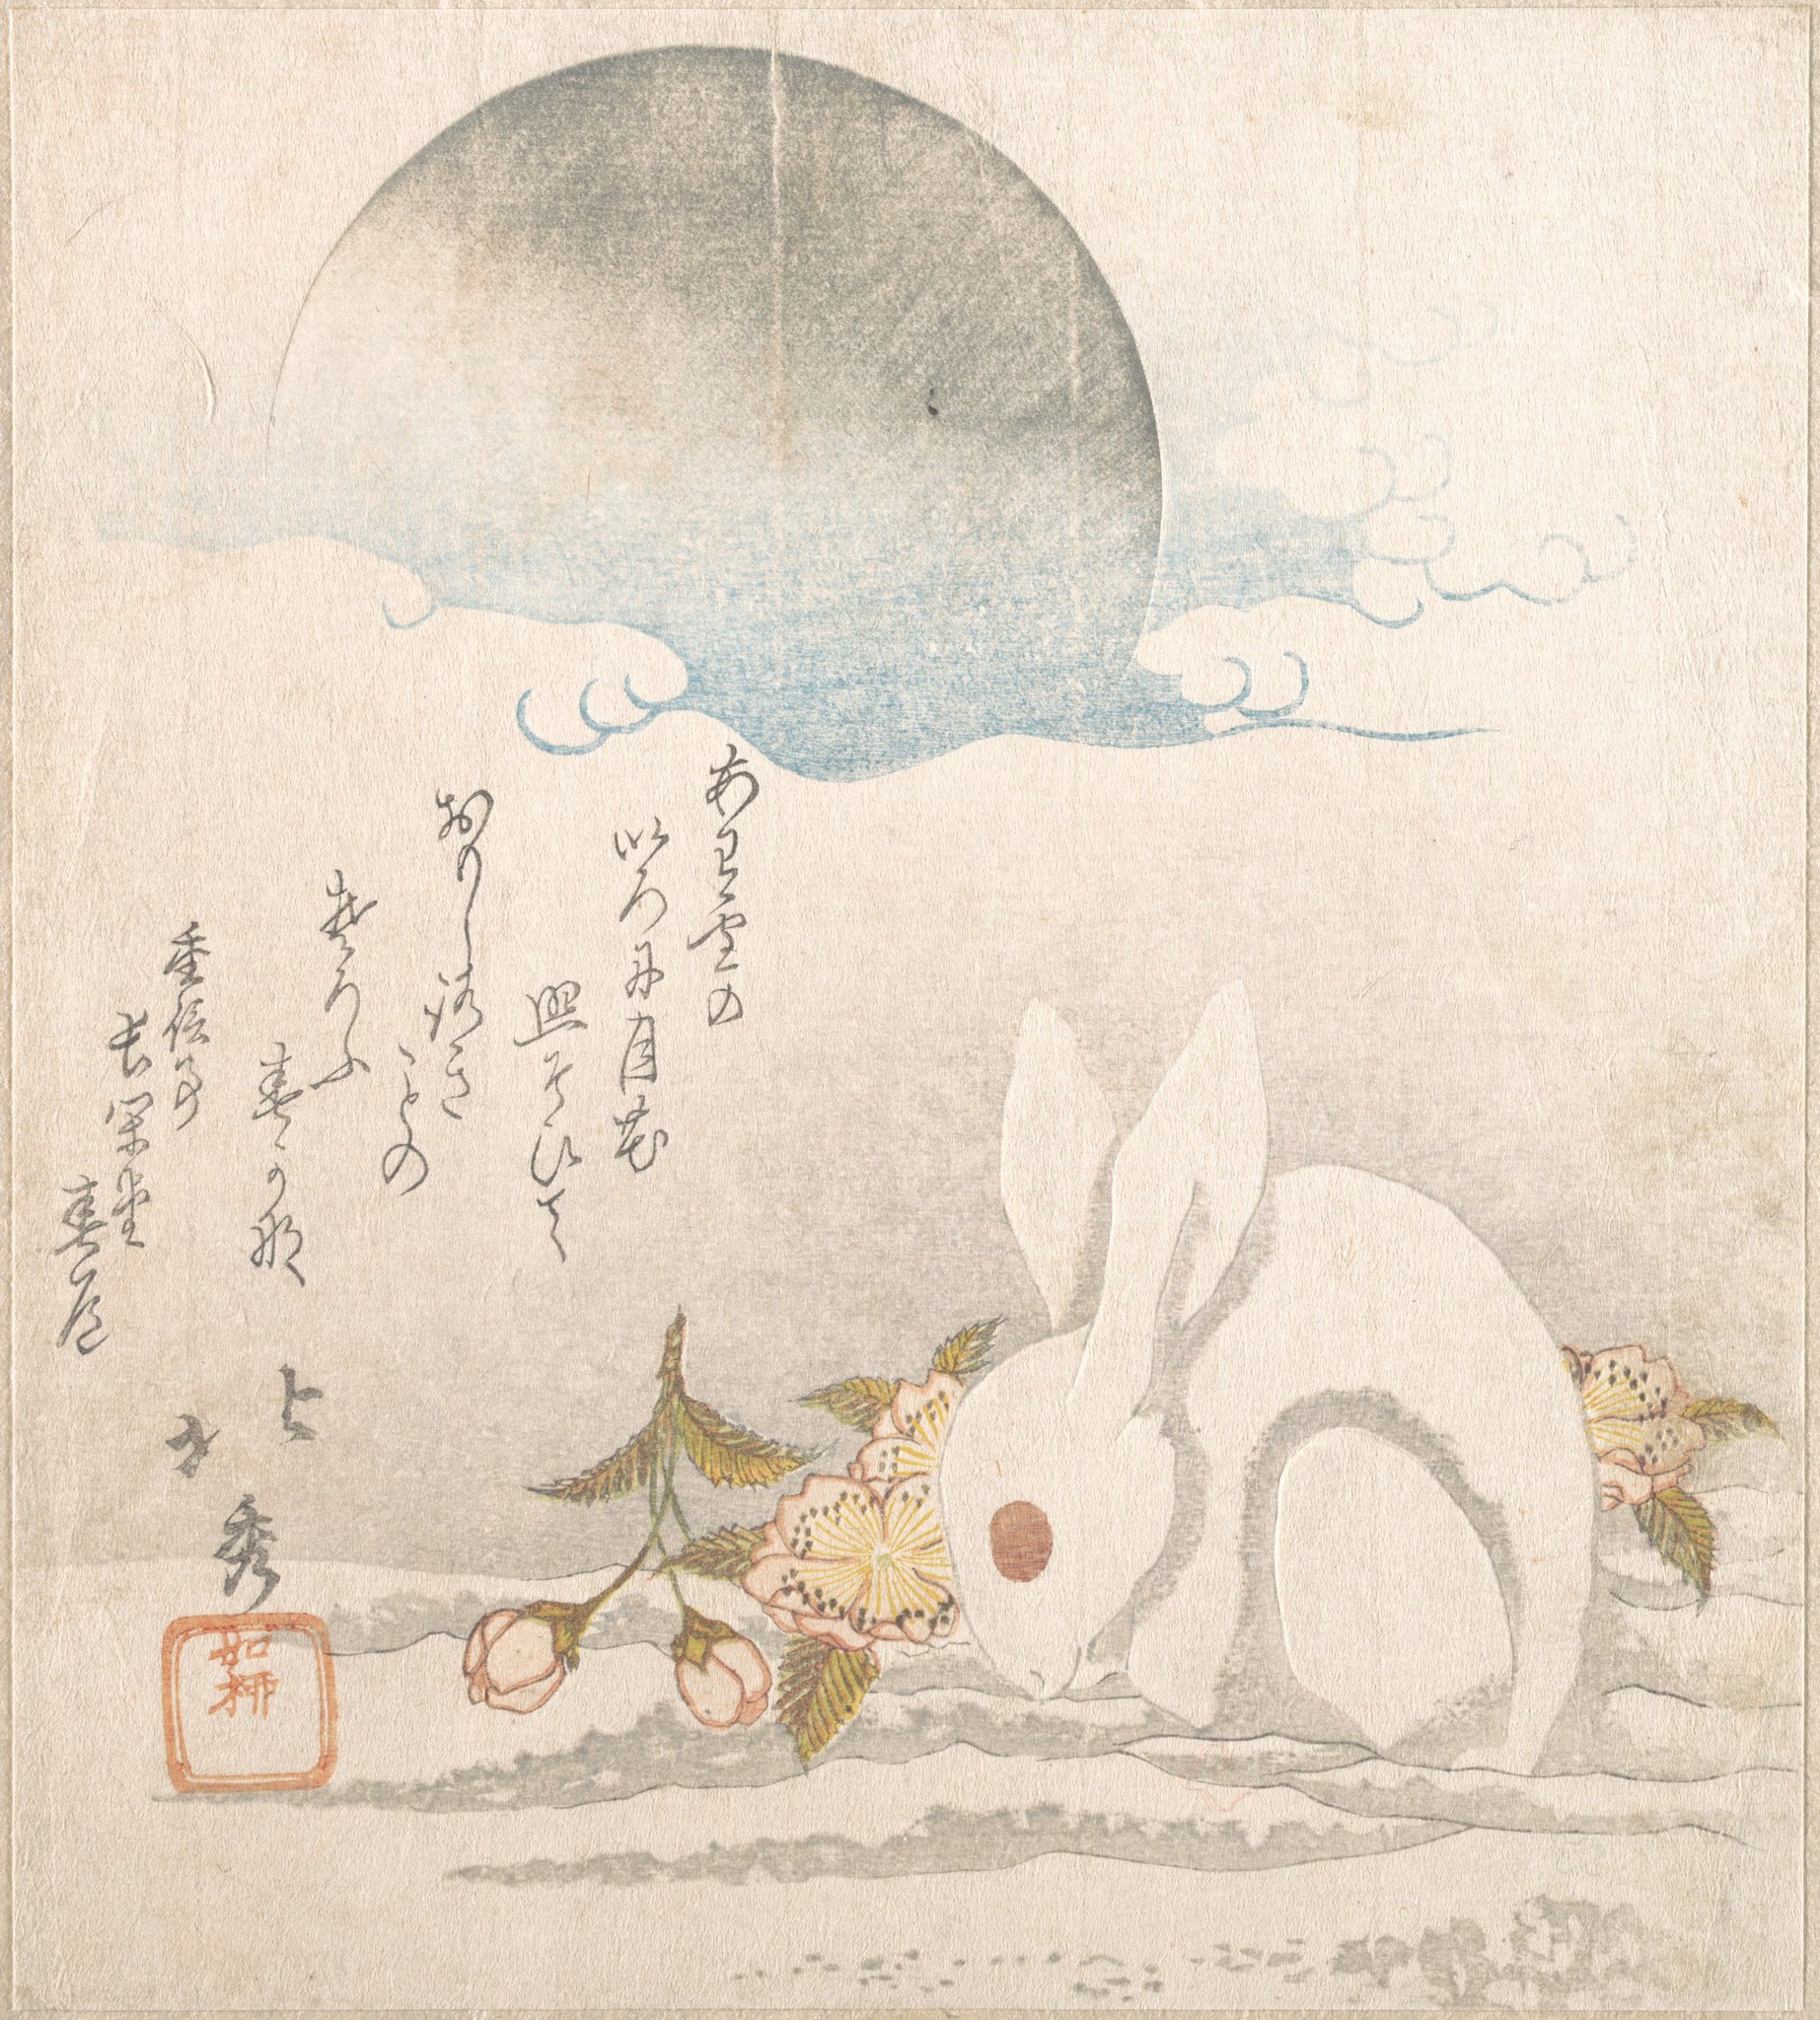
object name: print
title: Rabbit in the Snow beneath the Moon 月下の兎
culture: japanese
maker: katsushika hokushū 葛飾北秀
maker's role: artist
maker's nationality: japanese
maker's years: 1810-1830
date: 1819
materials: ink, paper, pigment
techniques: surimono, woodblock print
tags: rabbits,moon,flowers,snow